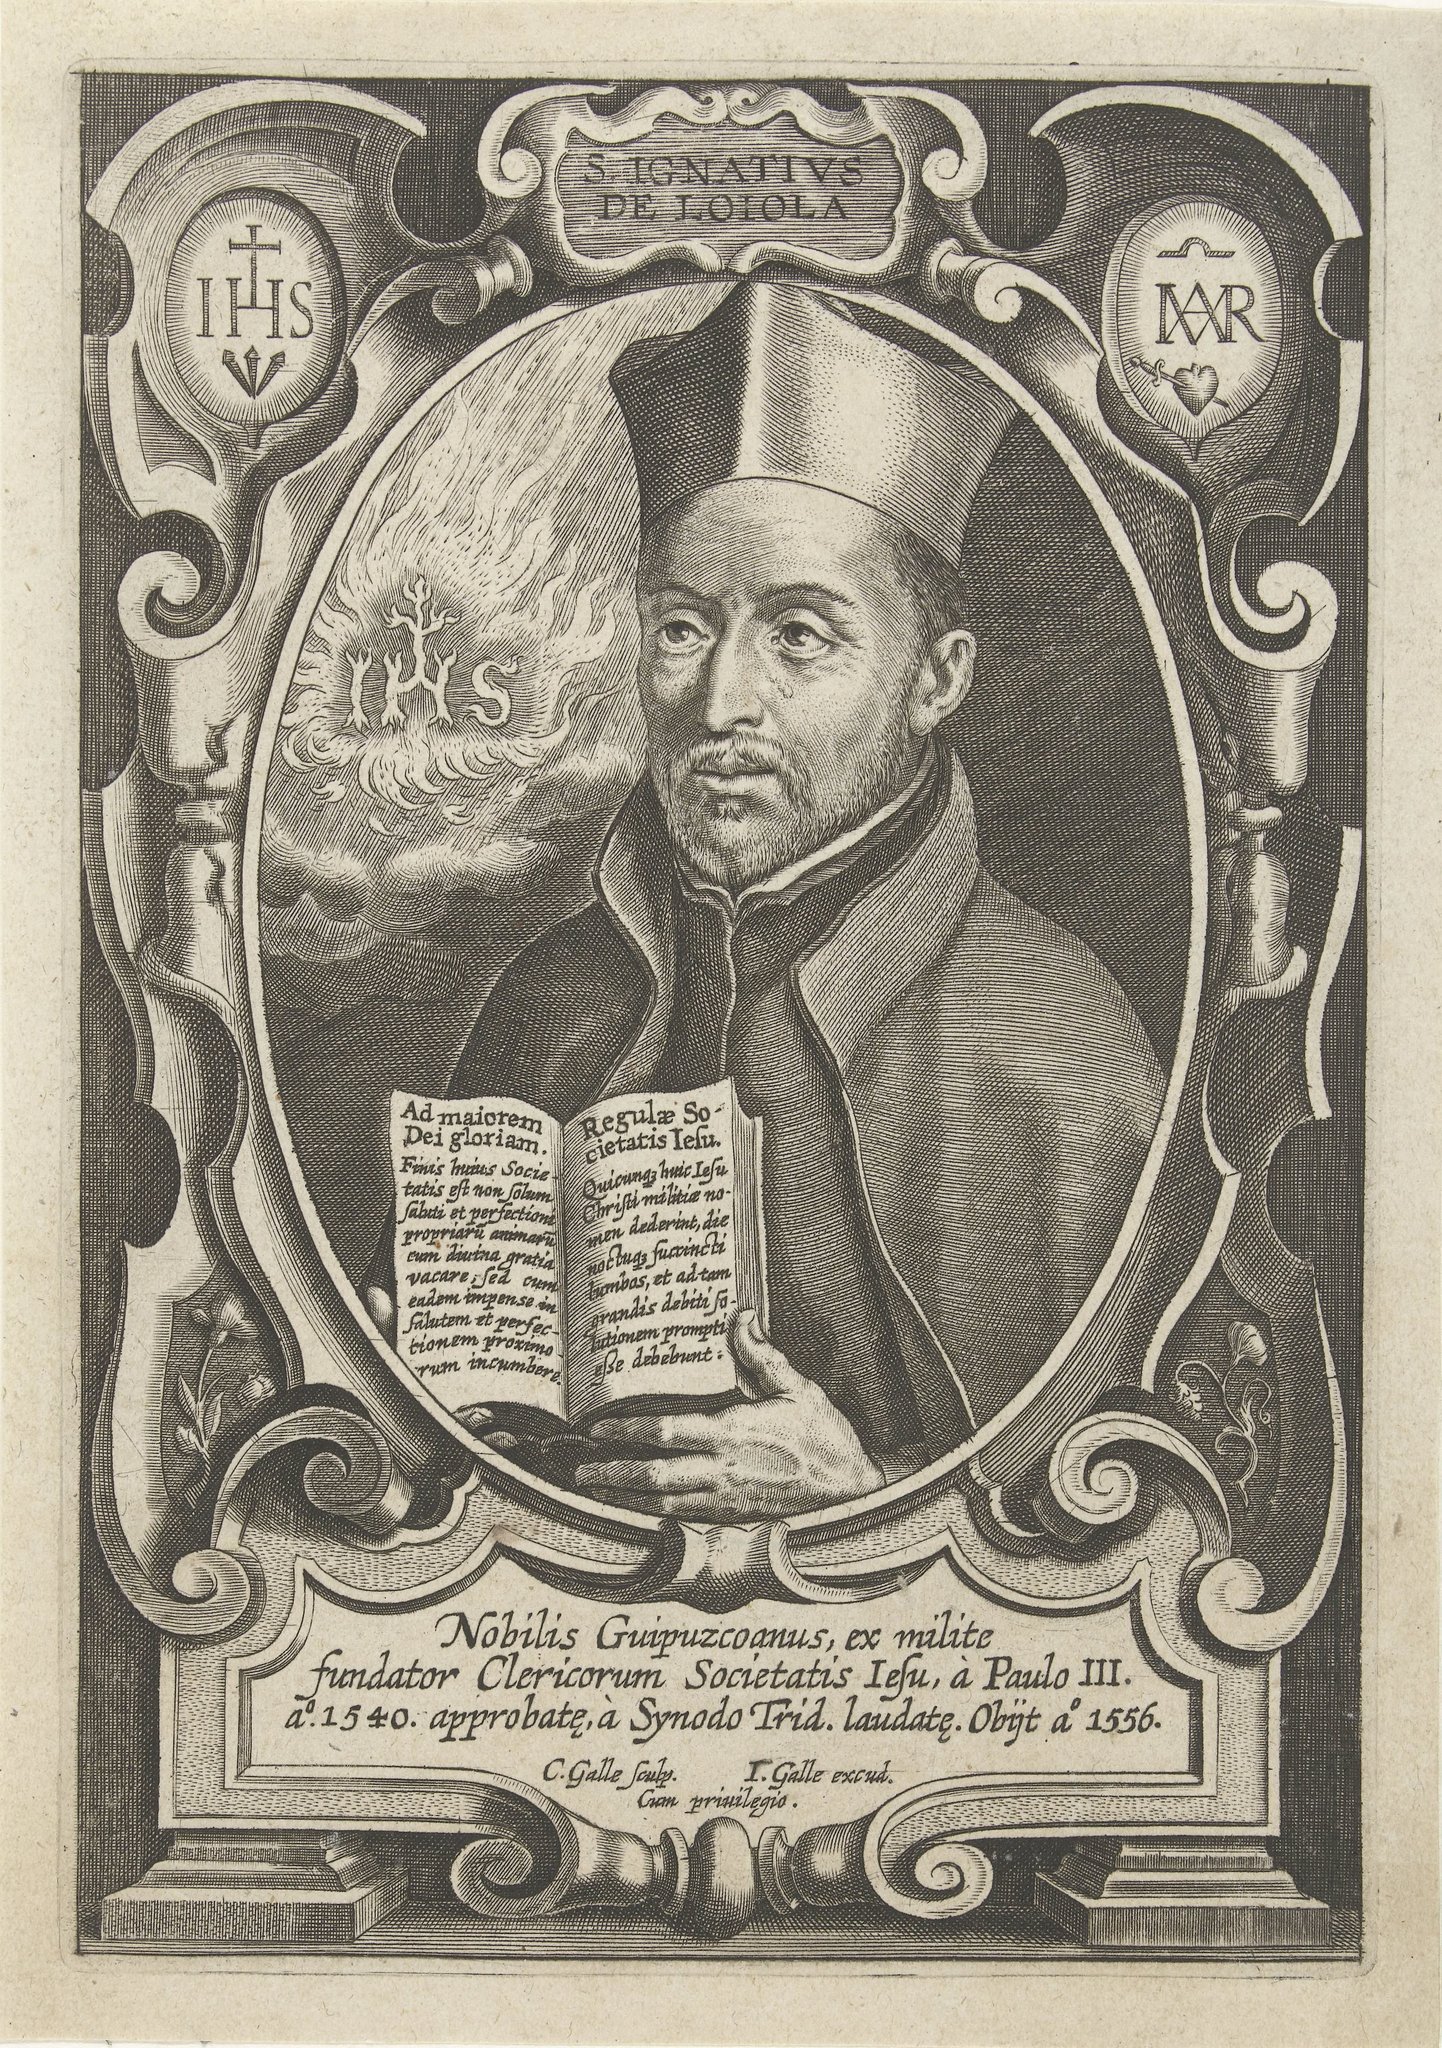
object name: print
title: S. Ignativs de Loiola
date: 1586-1676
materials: paper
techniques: engraving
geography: antwerp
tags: the founder of the jesuit order, ignatius of loyola; possible attributes: book (with 'ad majorem dei gloriam'), demon, dragon under feet, flames, flaming heart, globe, ihs monogram, skull (with crown), tears in eyes, torch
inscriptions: collector's mark: Lugt 2228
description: De heilige Ignatius van Loyola, stichter van de Jezuïetenorde toont een boek met de kloosterregels. Achter hem een Christusmonogram in vlammen, het symbool van de orde. Deel van een serie van afbeeldingen van de bekendste stichters van de kloosterorden.